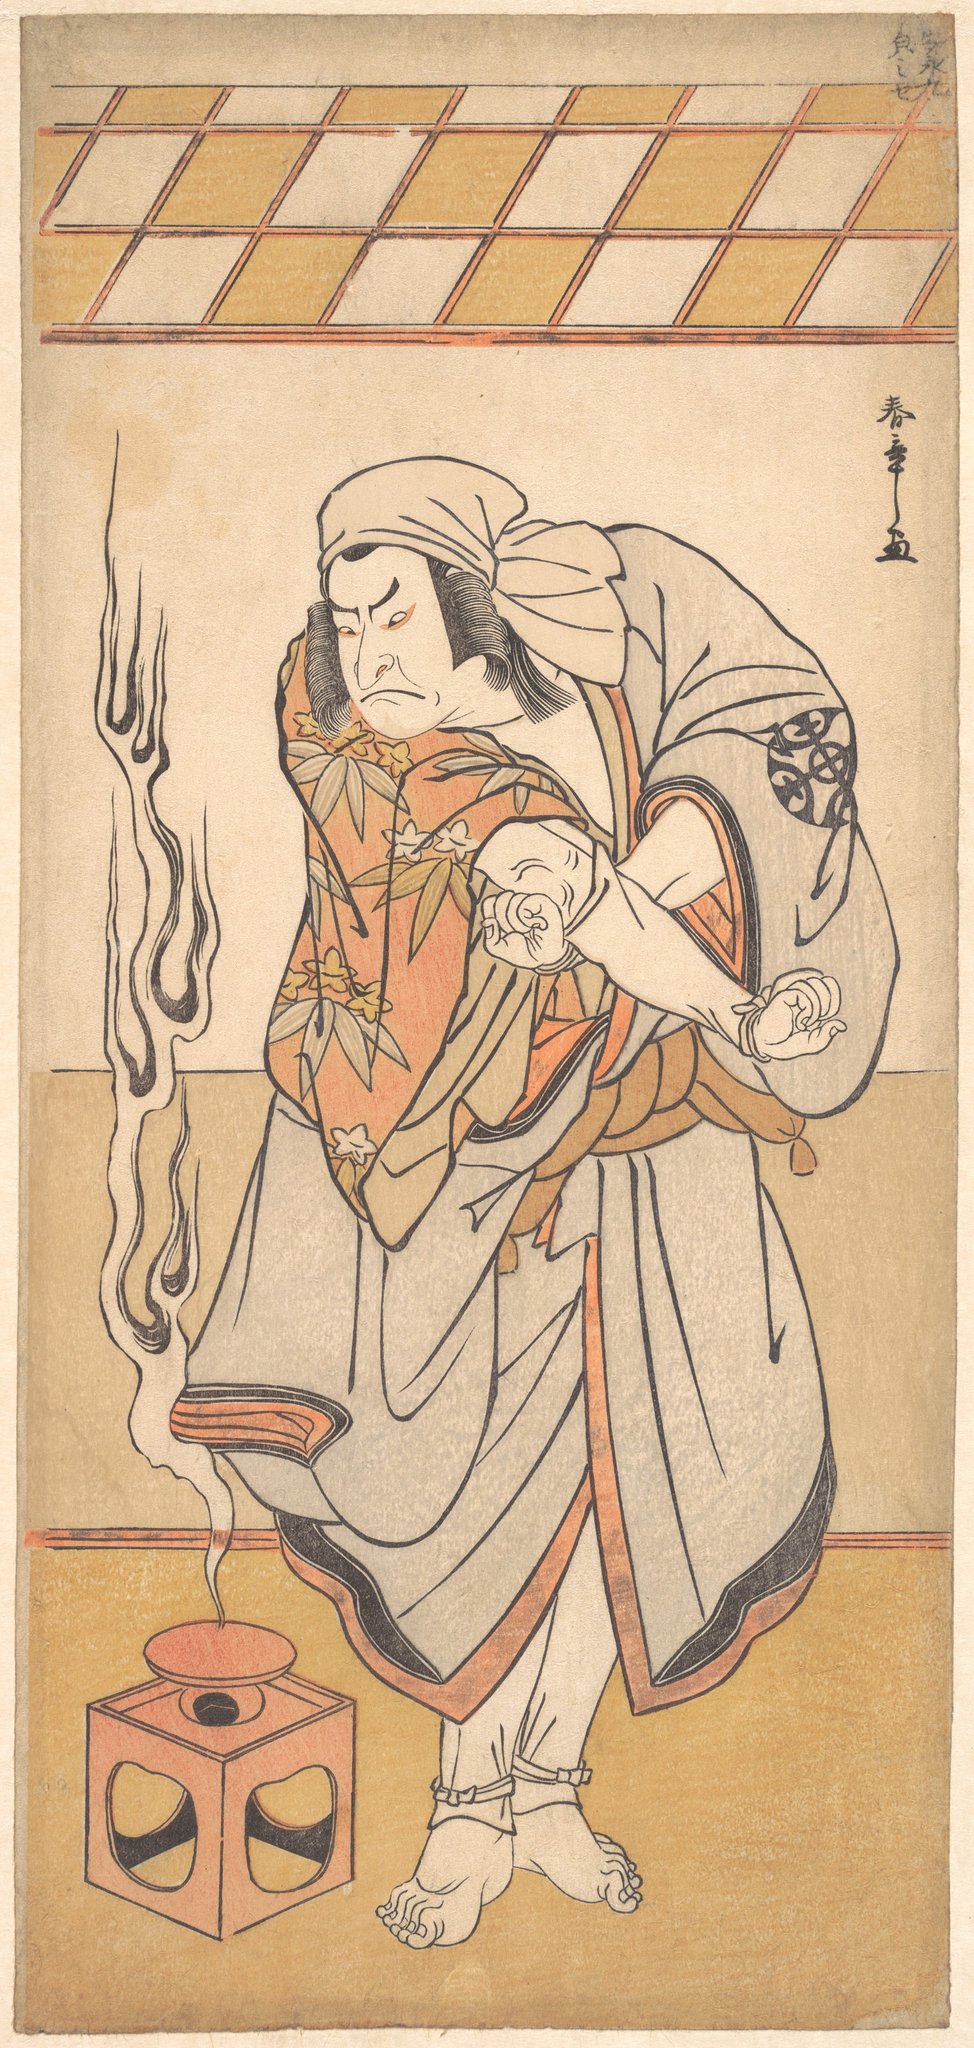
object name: woodblock print nishiki e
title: The First Nakamura Nakazo in the Role of Chinzei Hachiro in the Drama "Kite Kaeru nishiki no wakayagi"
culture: japanese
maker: katsukawa shunshō 勝川春章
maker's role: artist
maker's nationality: japanese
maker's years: 1726-1792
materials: ink, paper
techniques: nishiki e, woodblock print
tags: men,actors